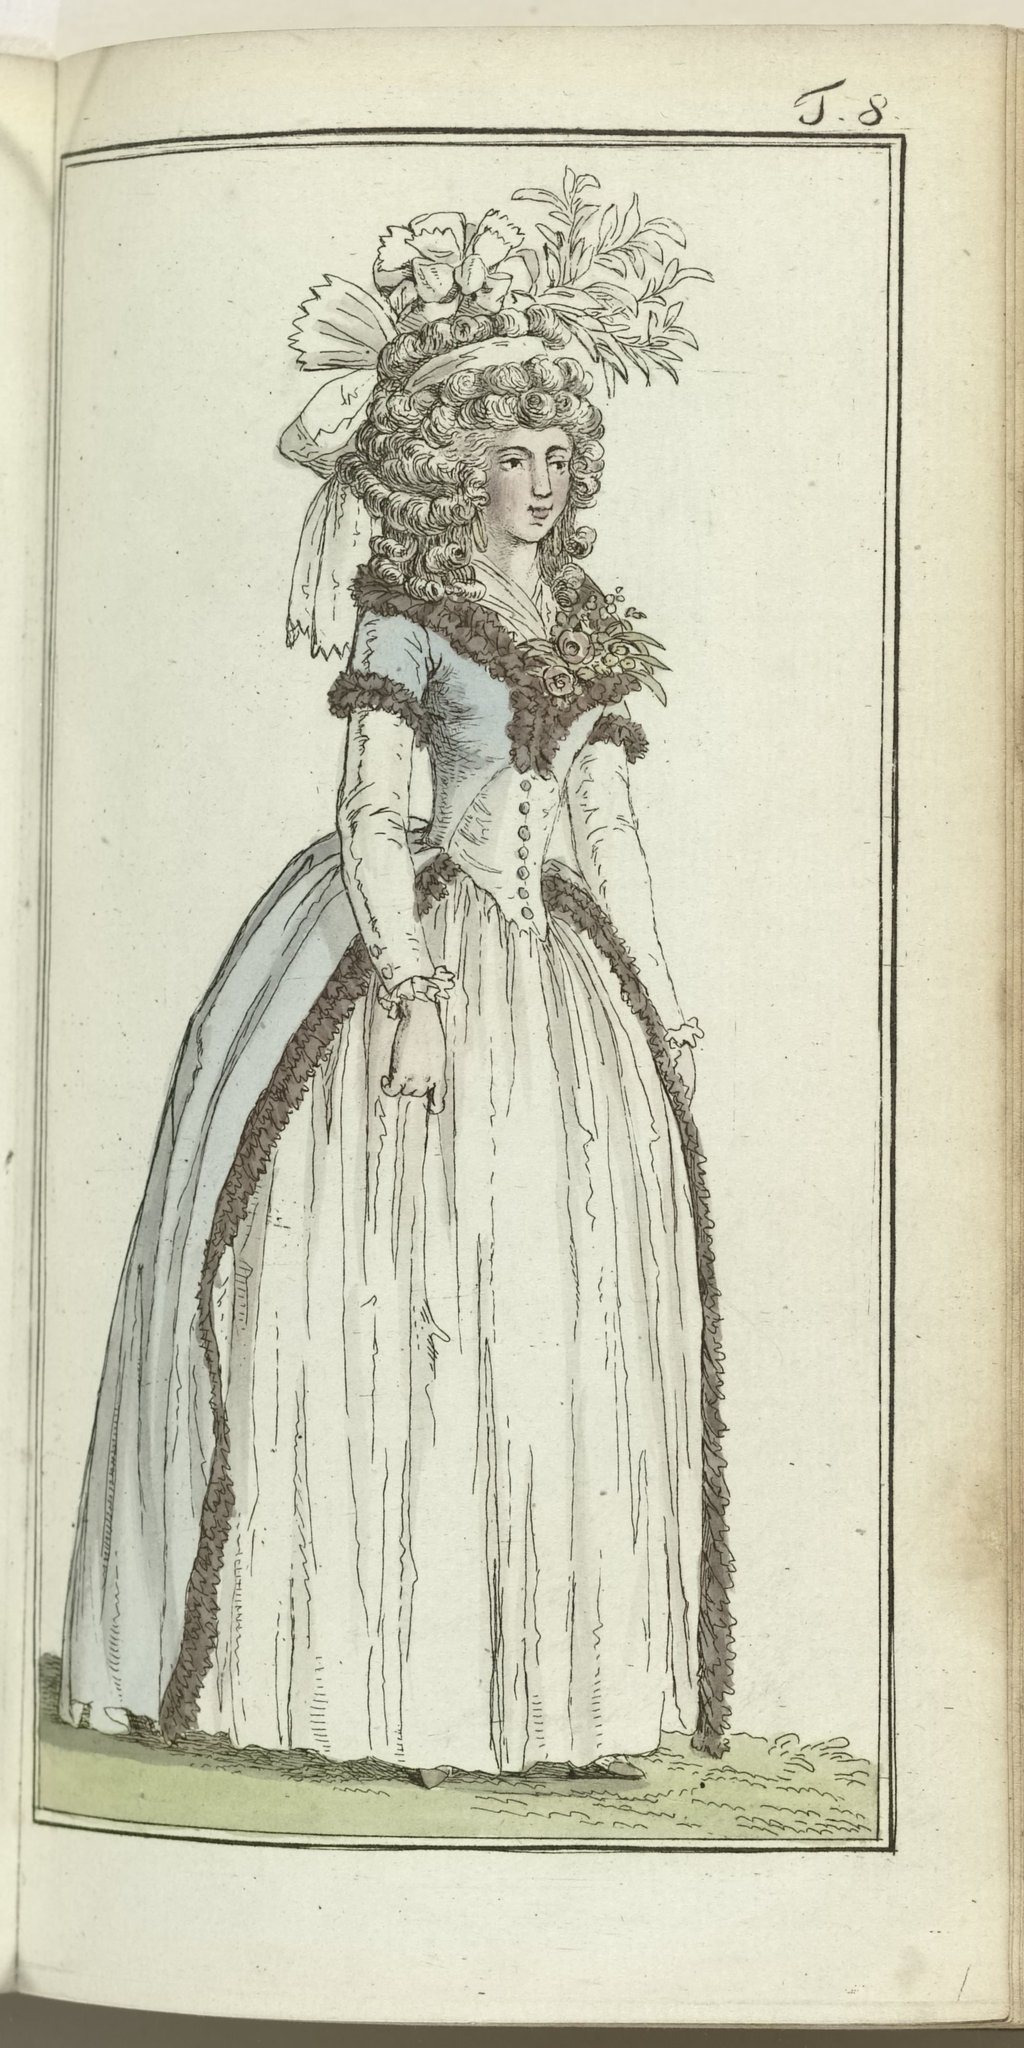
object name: magazine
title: Journal des Luxus und der Moden 1790, Band V, T.8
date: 1790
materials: paper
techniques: etching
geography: weimar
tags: fashion plates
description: Prent uit het modetijdschrift Journal des Luxus und der Moden, uitgegeven door Friedrich Justin Bertuch en Georg Melchior Kraus, Weimar, 1786-1826.